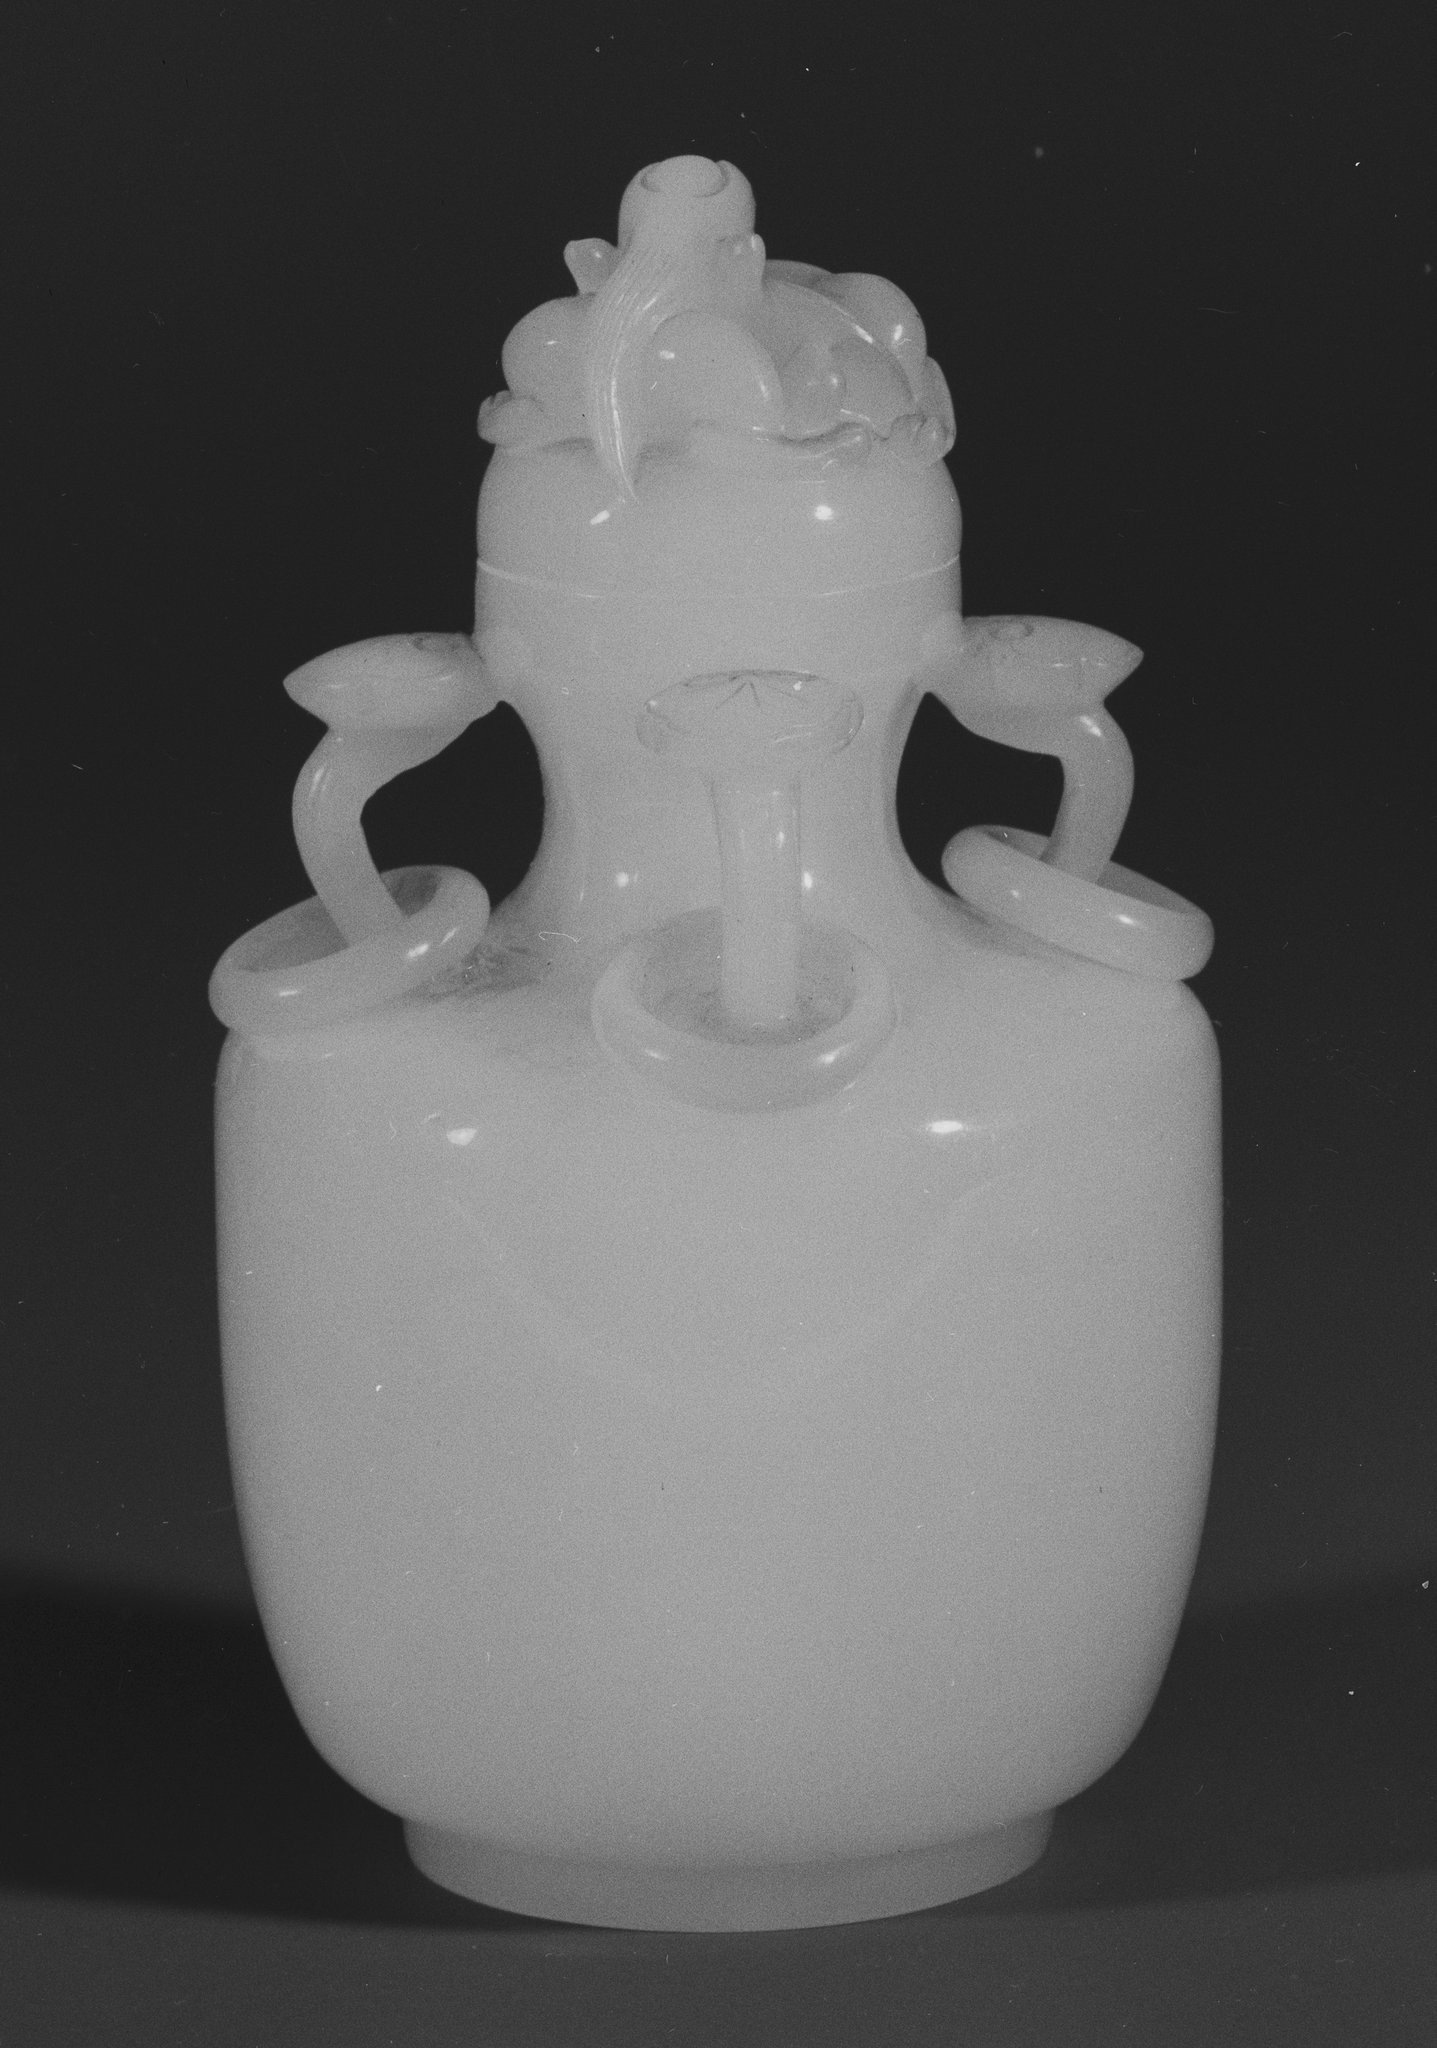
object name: covered vase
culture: chinese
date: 1701-1800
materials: jade